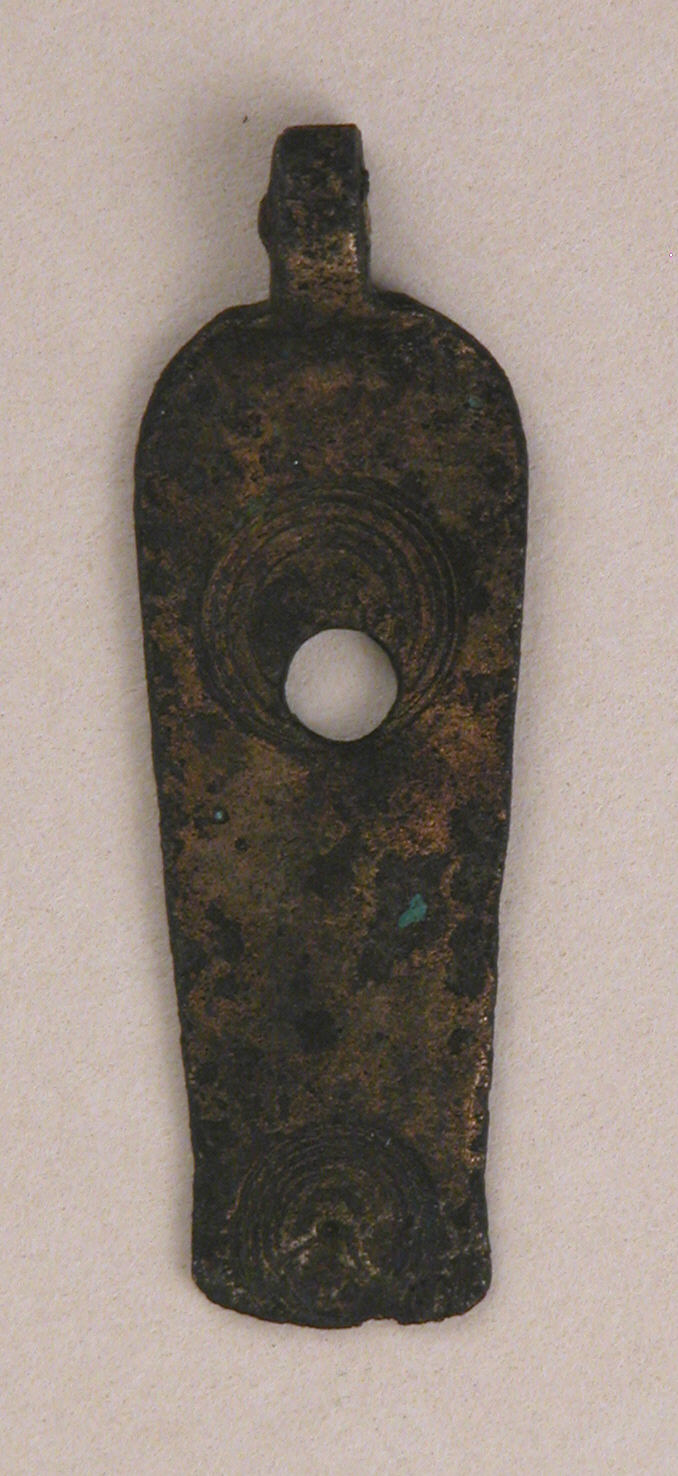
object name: hinge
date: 401-800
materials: bronze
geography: palestine